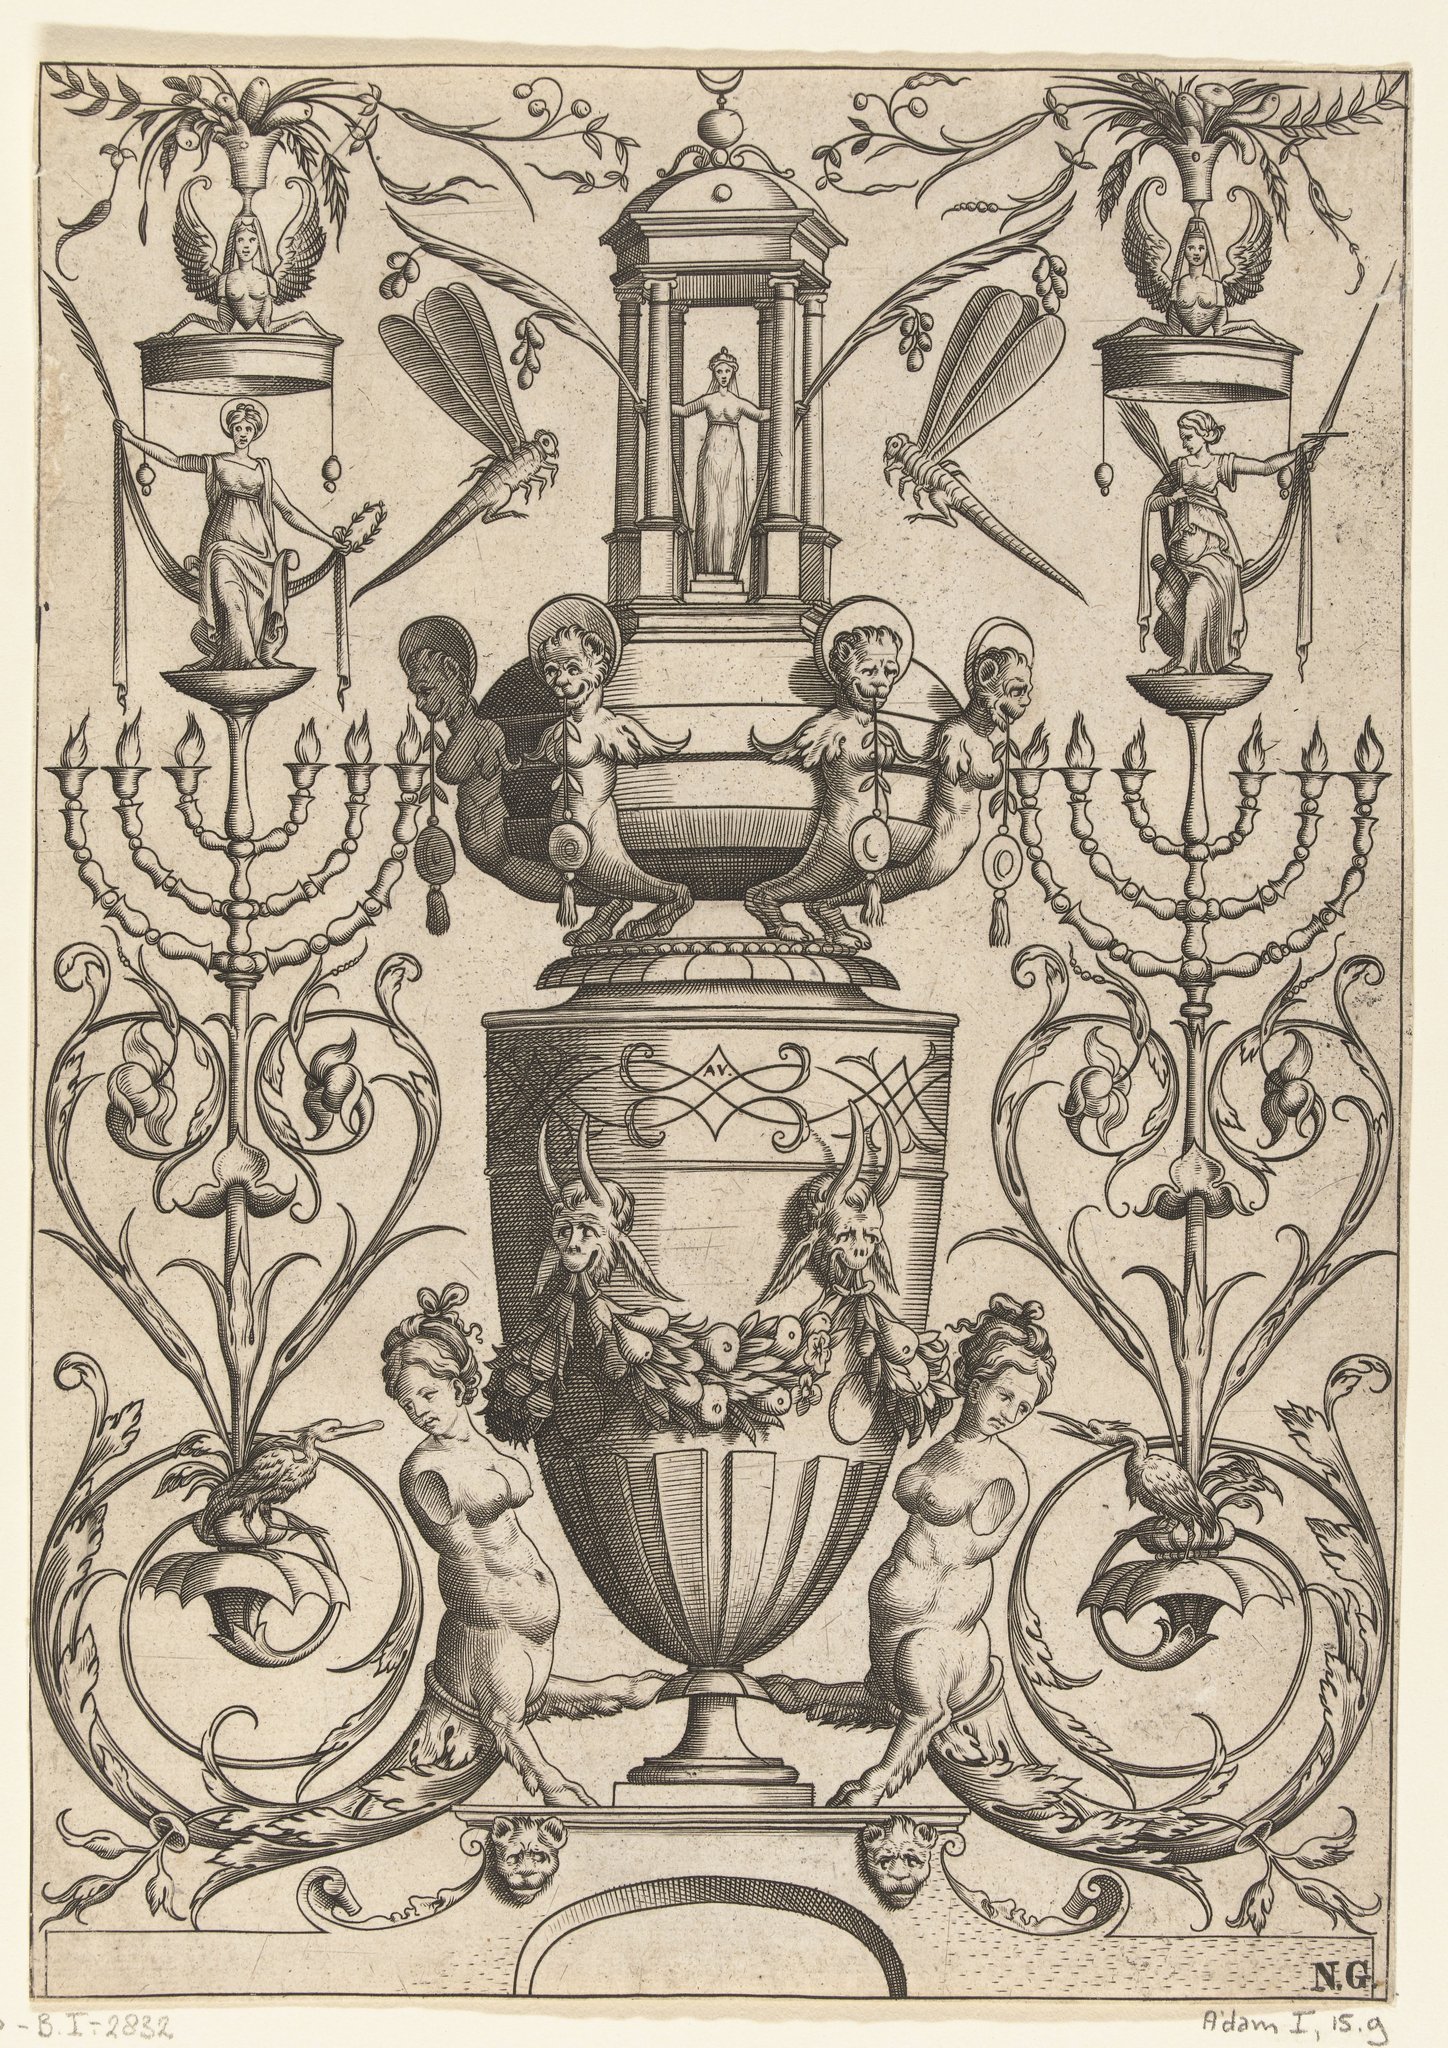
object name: print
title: Dubbele bokaal waarvan de deksel bekroond wordt door een tempeltje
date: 1516-1556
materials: paper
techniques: engraving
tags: chandelier, candelabrum, cup, victory, fame; 'fama', 'fama buona', 'fama chiara' (ripa)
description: In het tempeltje staat een vrouw. Links en rechts boven staan op een zesarmige kandelaar onder een baldakijn, respectievelijk Fama en Victoria. Blad uit serie van 9 bladen.